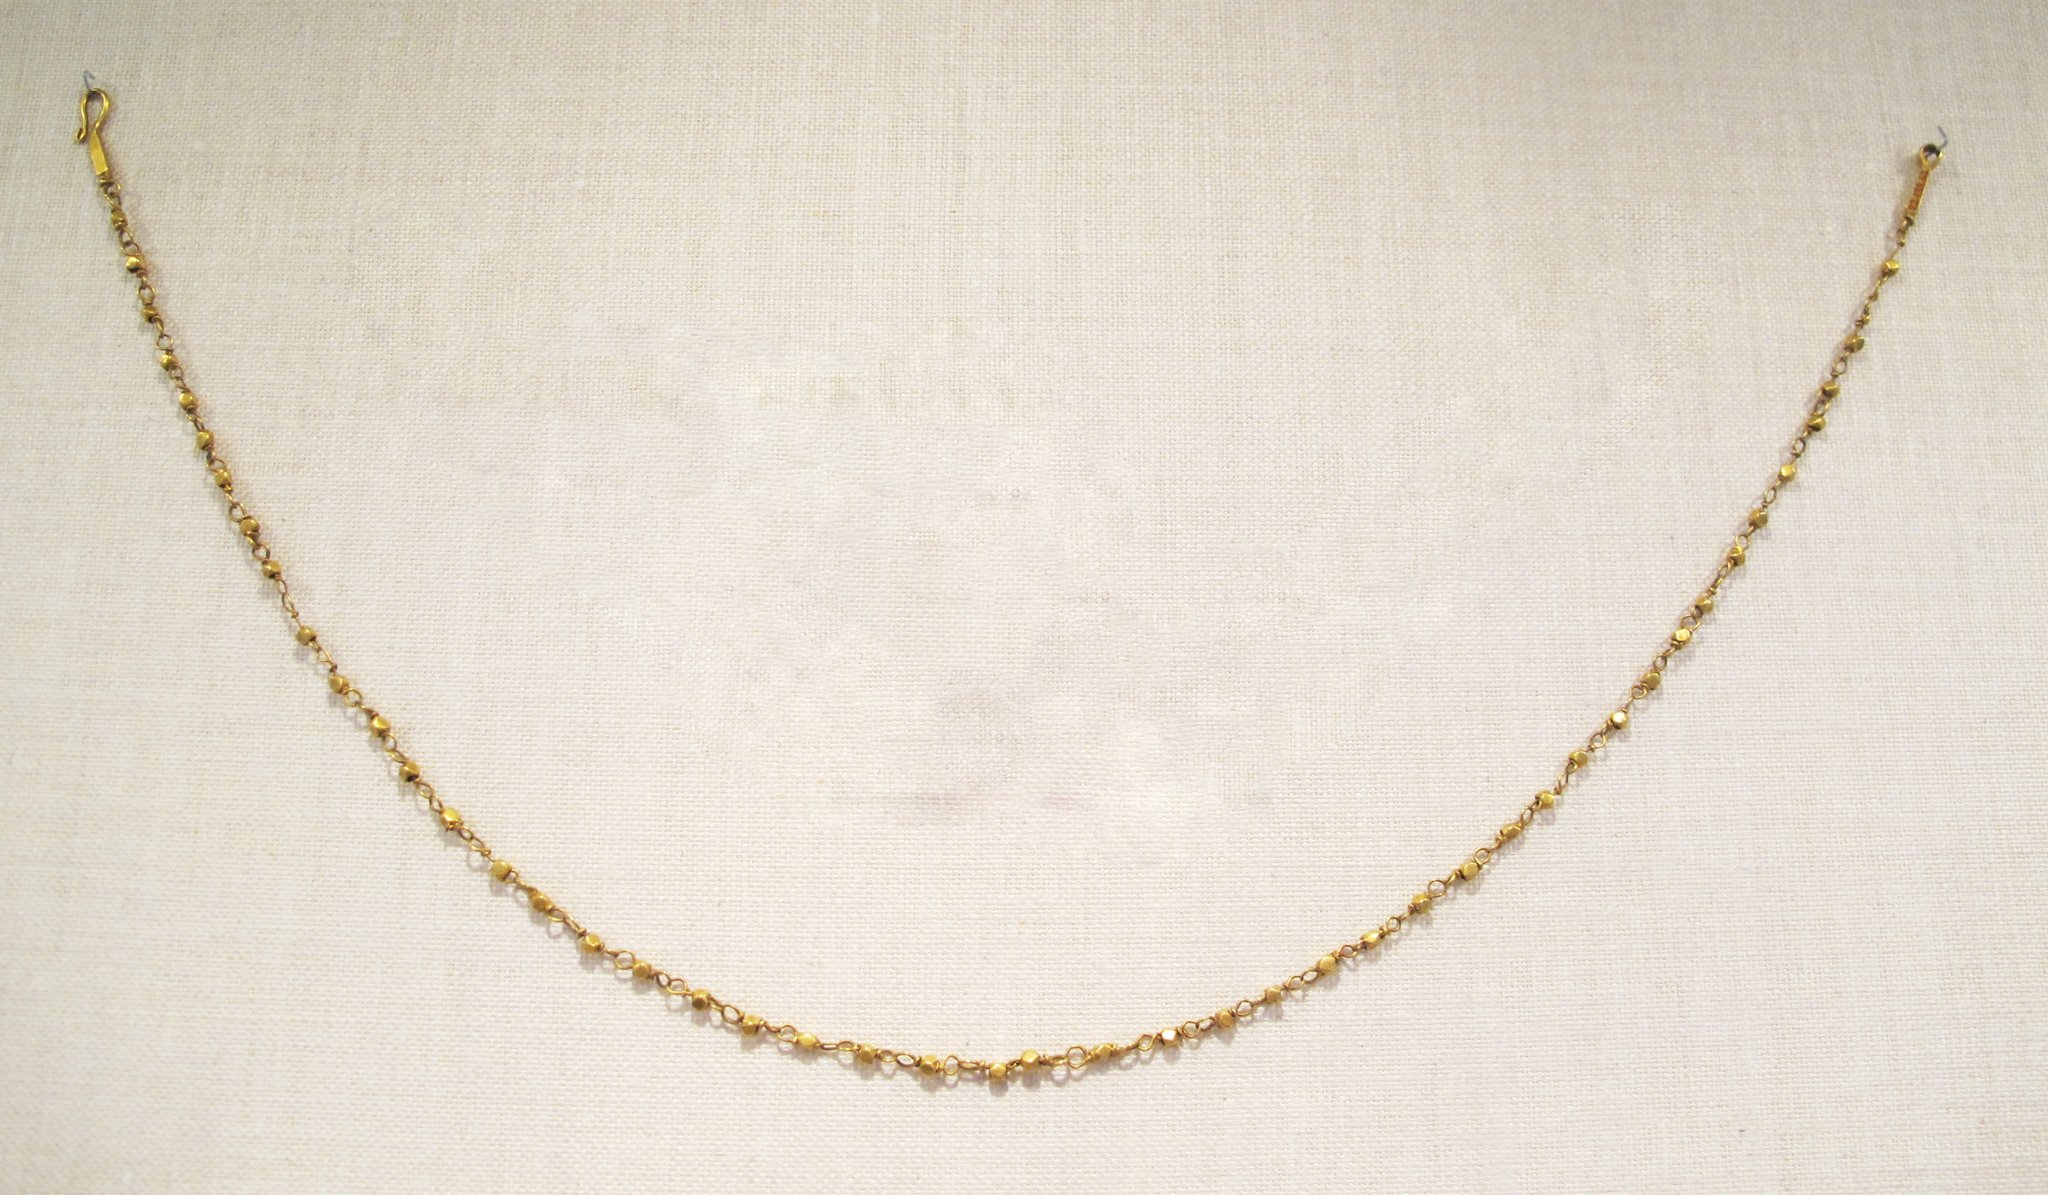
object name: necklace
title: Gold necklace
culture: roman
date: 100 BCE-100 CE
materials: gold